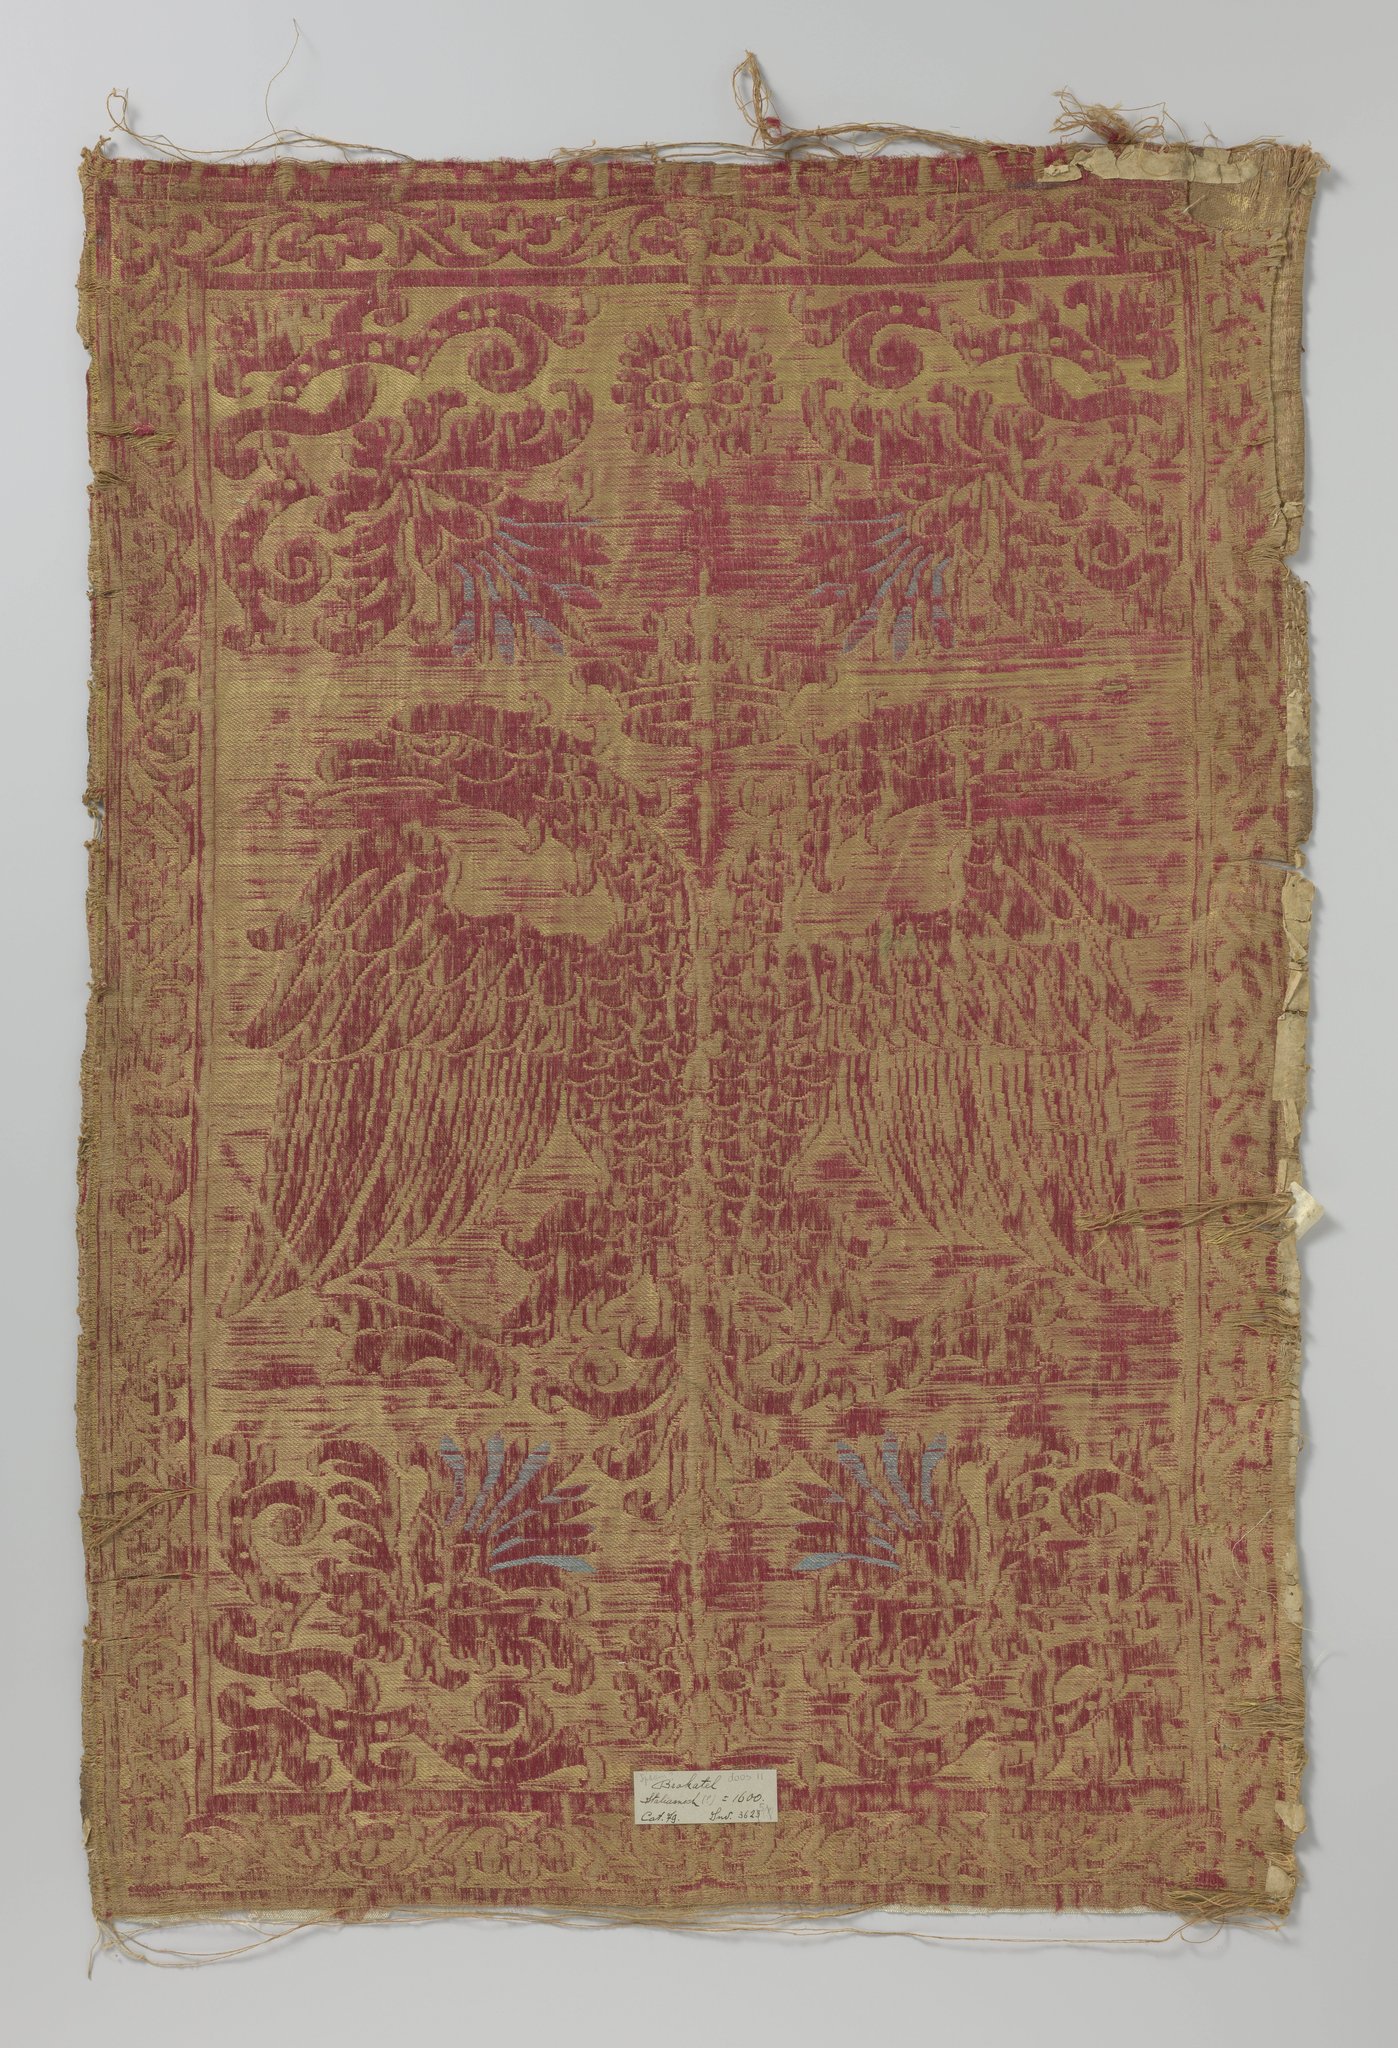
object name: fragment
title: Fragment of doek van gele en rode satijnbrokaat met een patroon van dubbele gekroonde adelaars met in de hoeken bloemornamenten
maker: Anonymous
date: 1590-1610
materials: textile, linen, silk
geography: italy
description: Fragment of doek van gele en rode satijnbrokaat, plaatselijk een blauwe inslag, met een patroon van dubbele gekroonde adelaars, in de hoeken omgeven door een bloemornament en omlijst door een rand van strakke rinceaux.